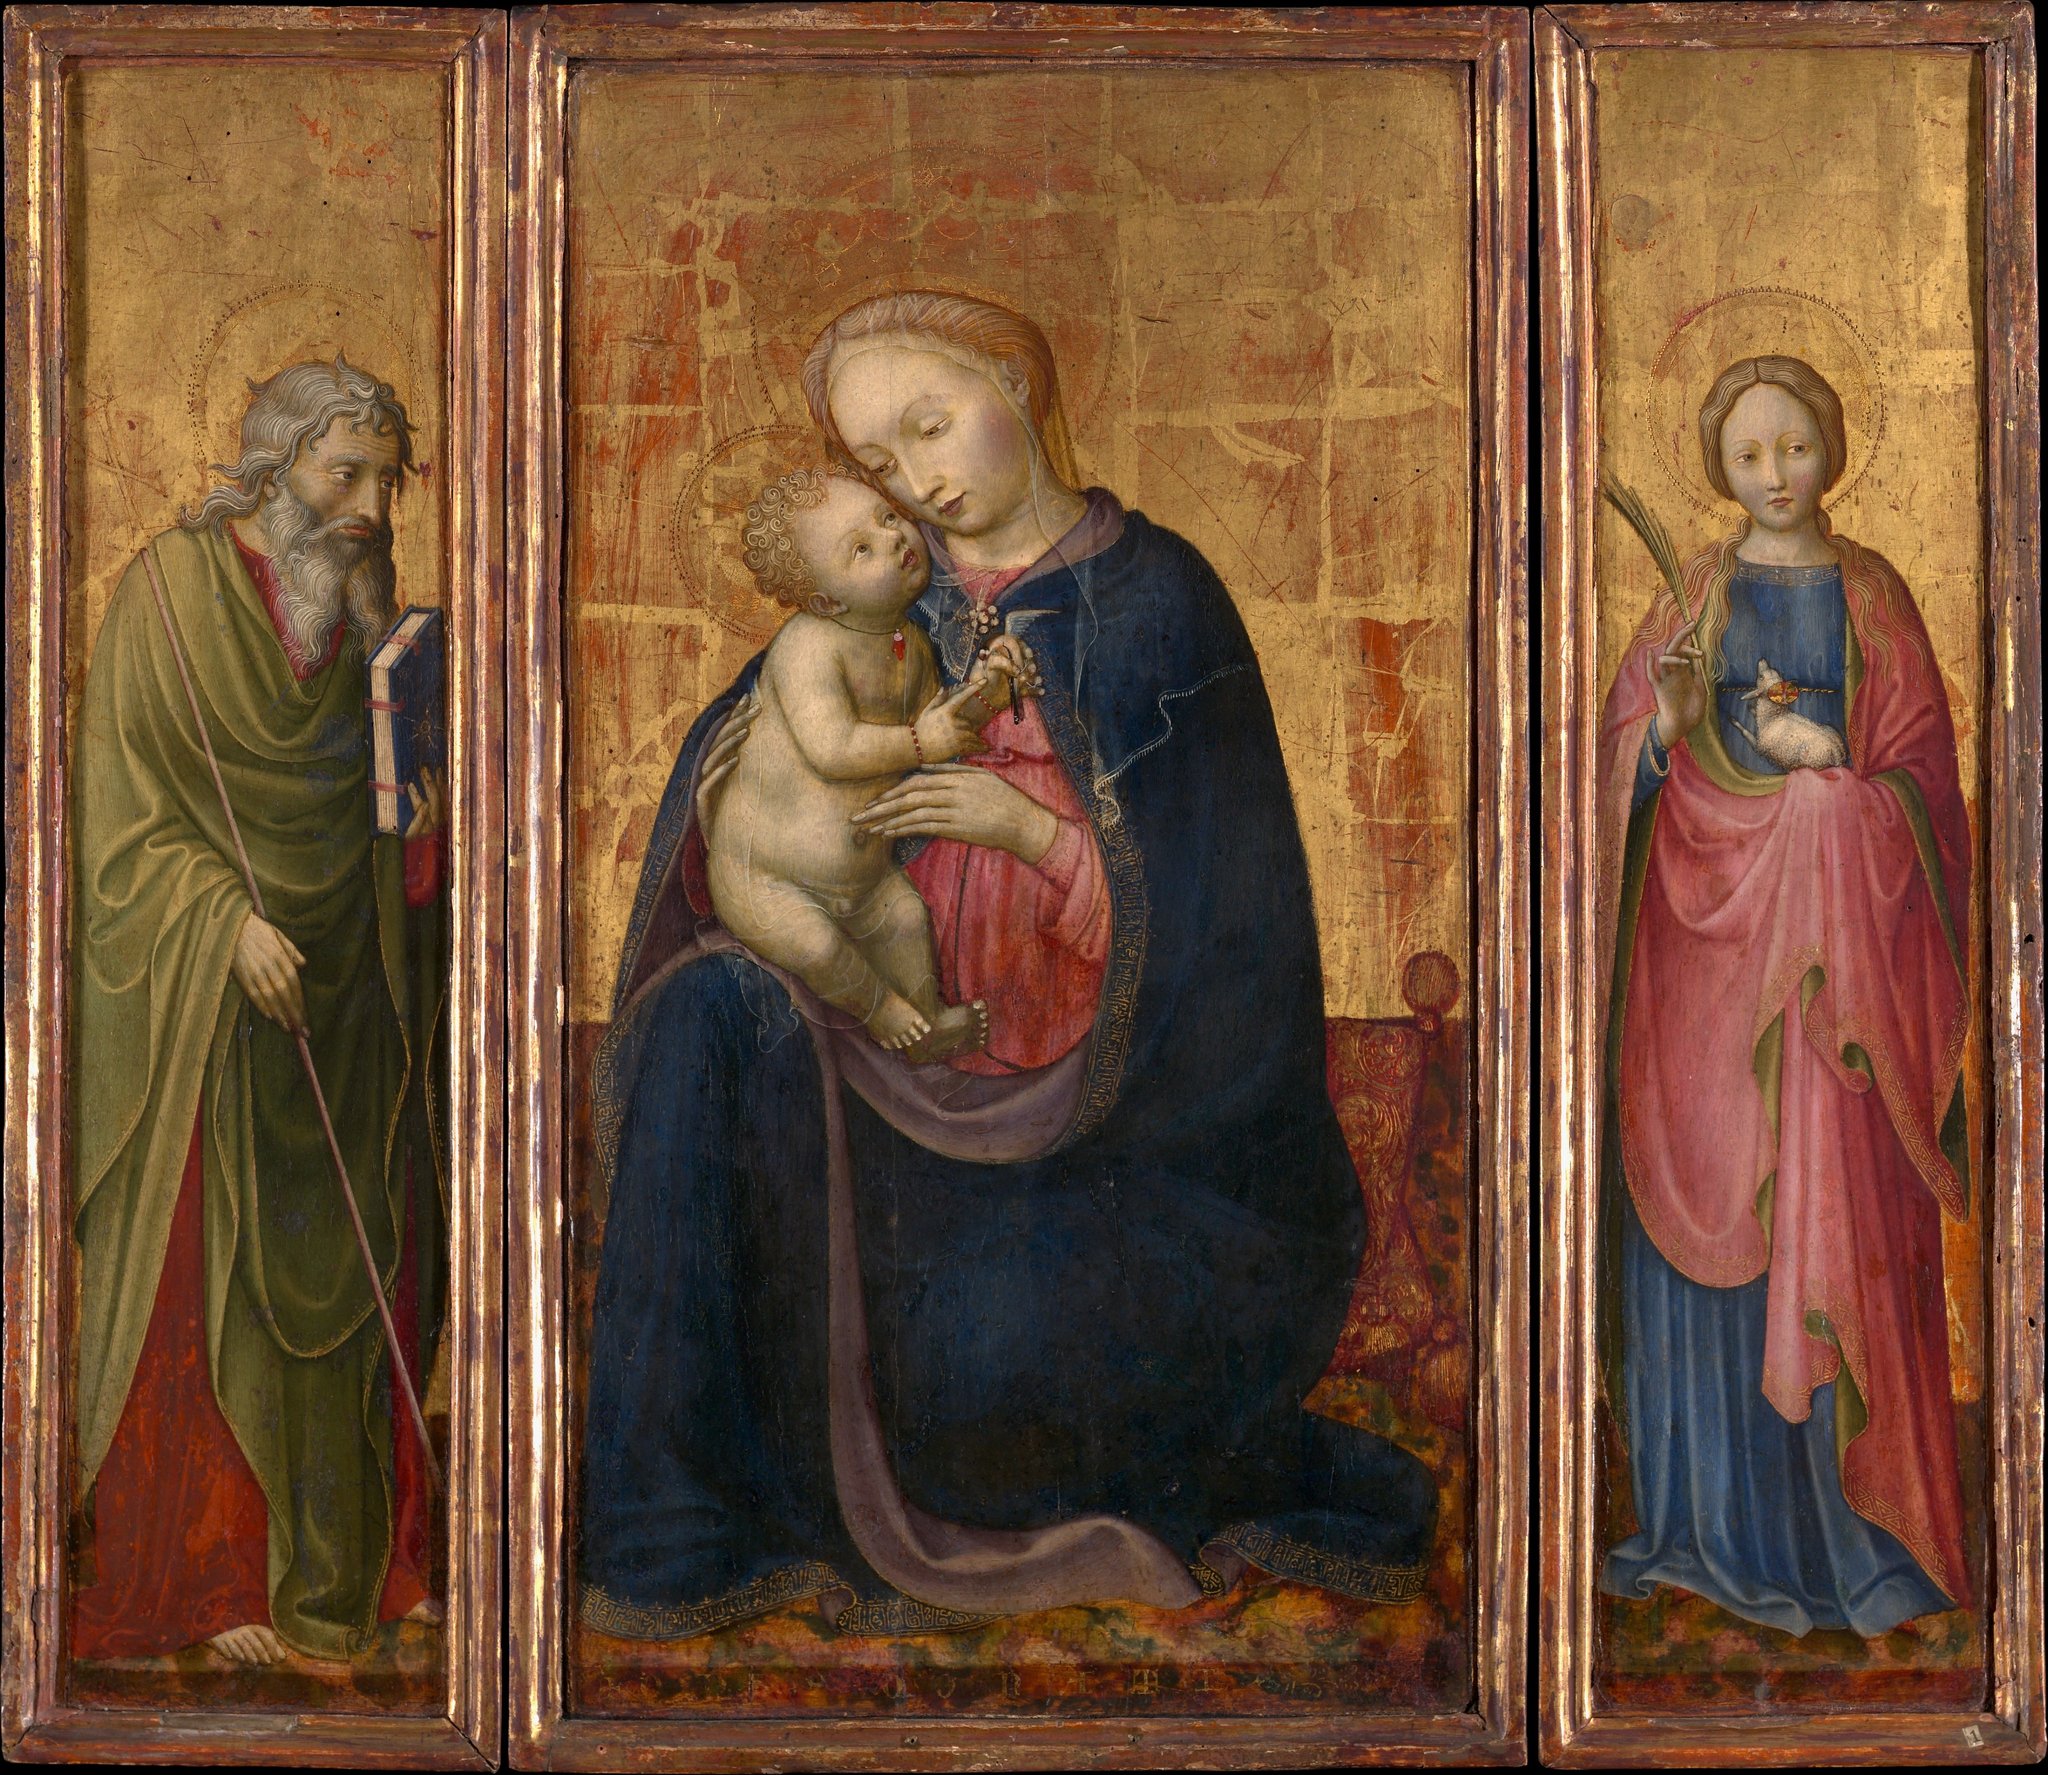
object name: painting, triptych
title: Madonna and Child with Saints Philip and Agnes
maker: donato de' bardi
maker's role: artist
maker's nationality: italian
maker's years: 1426-1451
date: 1425-1430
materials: gold leaf, paint, wood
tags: men,women,madonna and child,saints